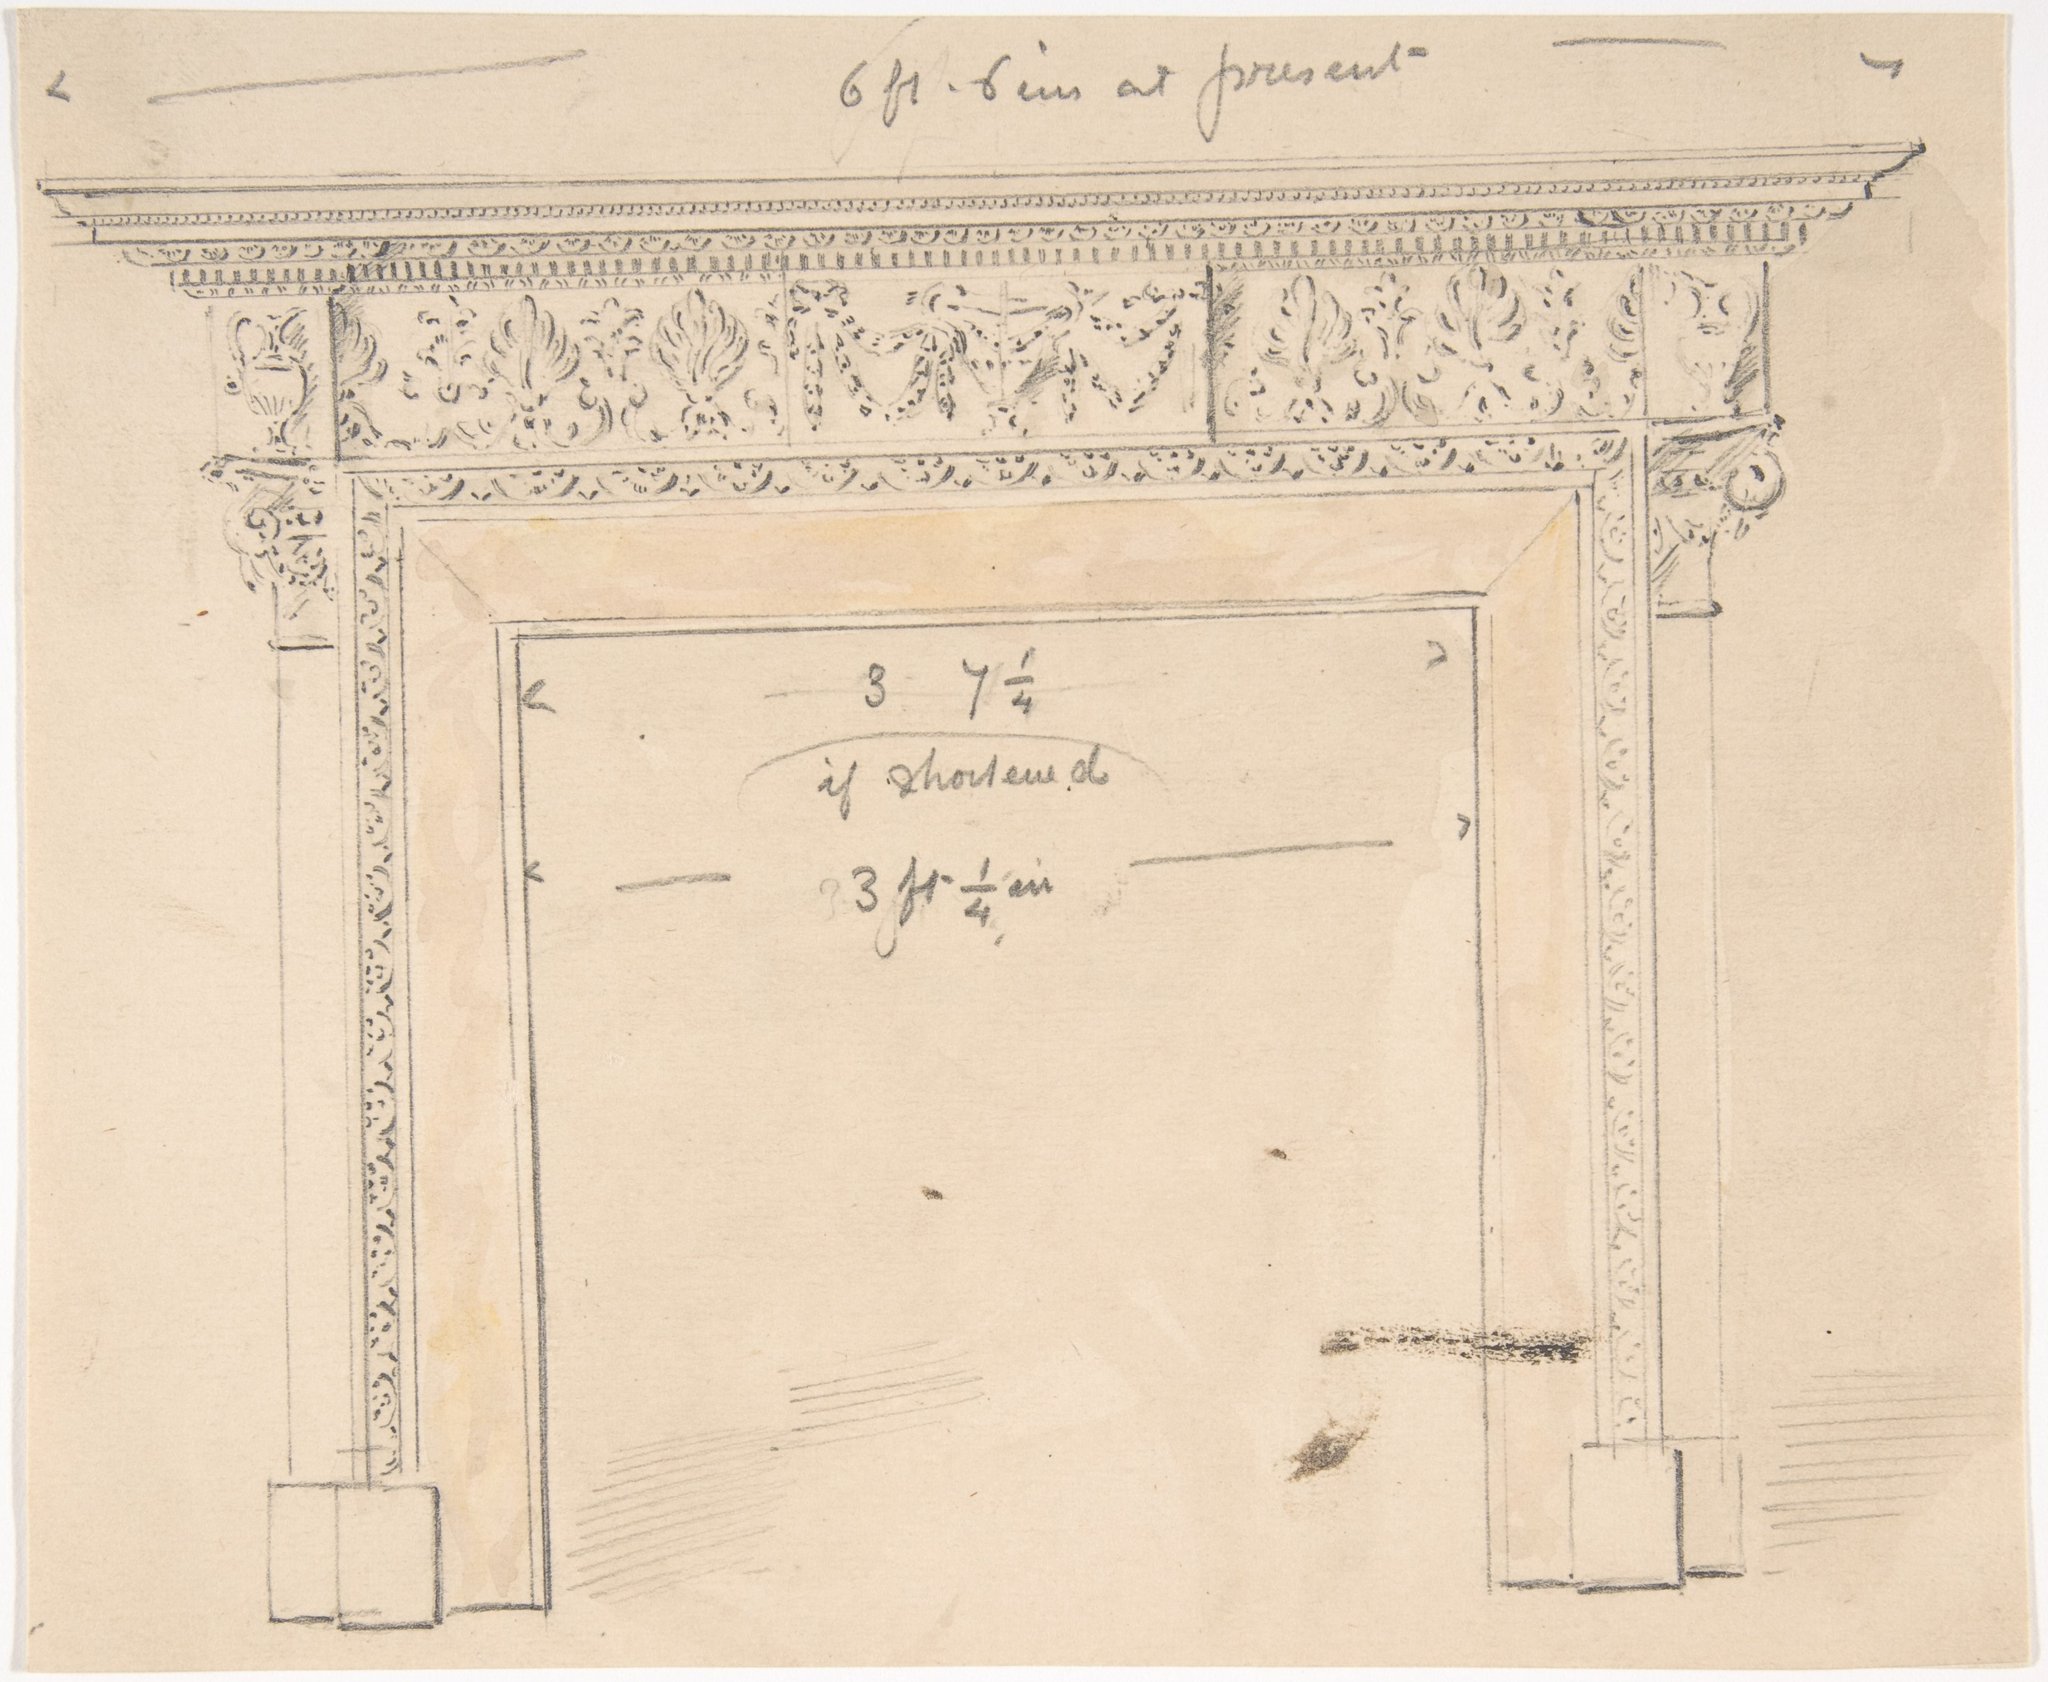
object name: drawing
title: Design for a Fireplace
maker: anonymous, british, 19th century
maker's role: artist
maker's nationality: british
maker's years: 1800-1900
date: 1801-1850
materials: ink, watercolor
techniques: pen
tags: fireplaces